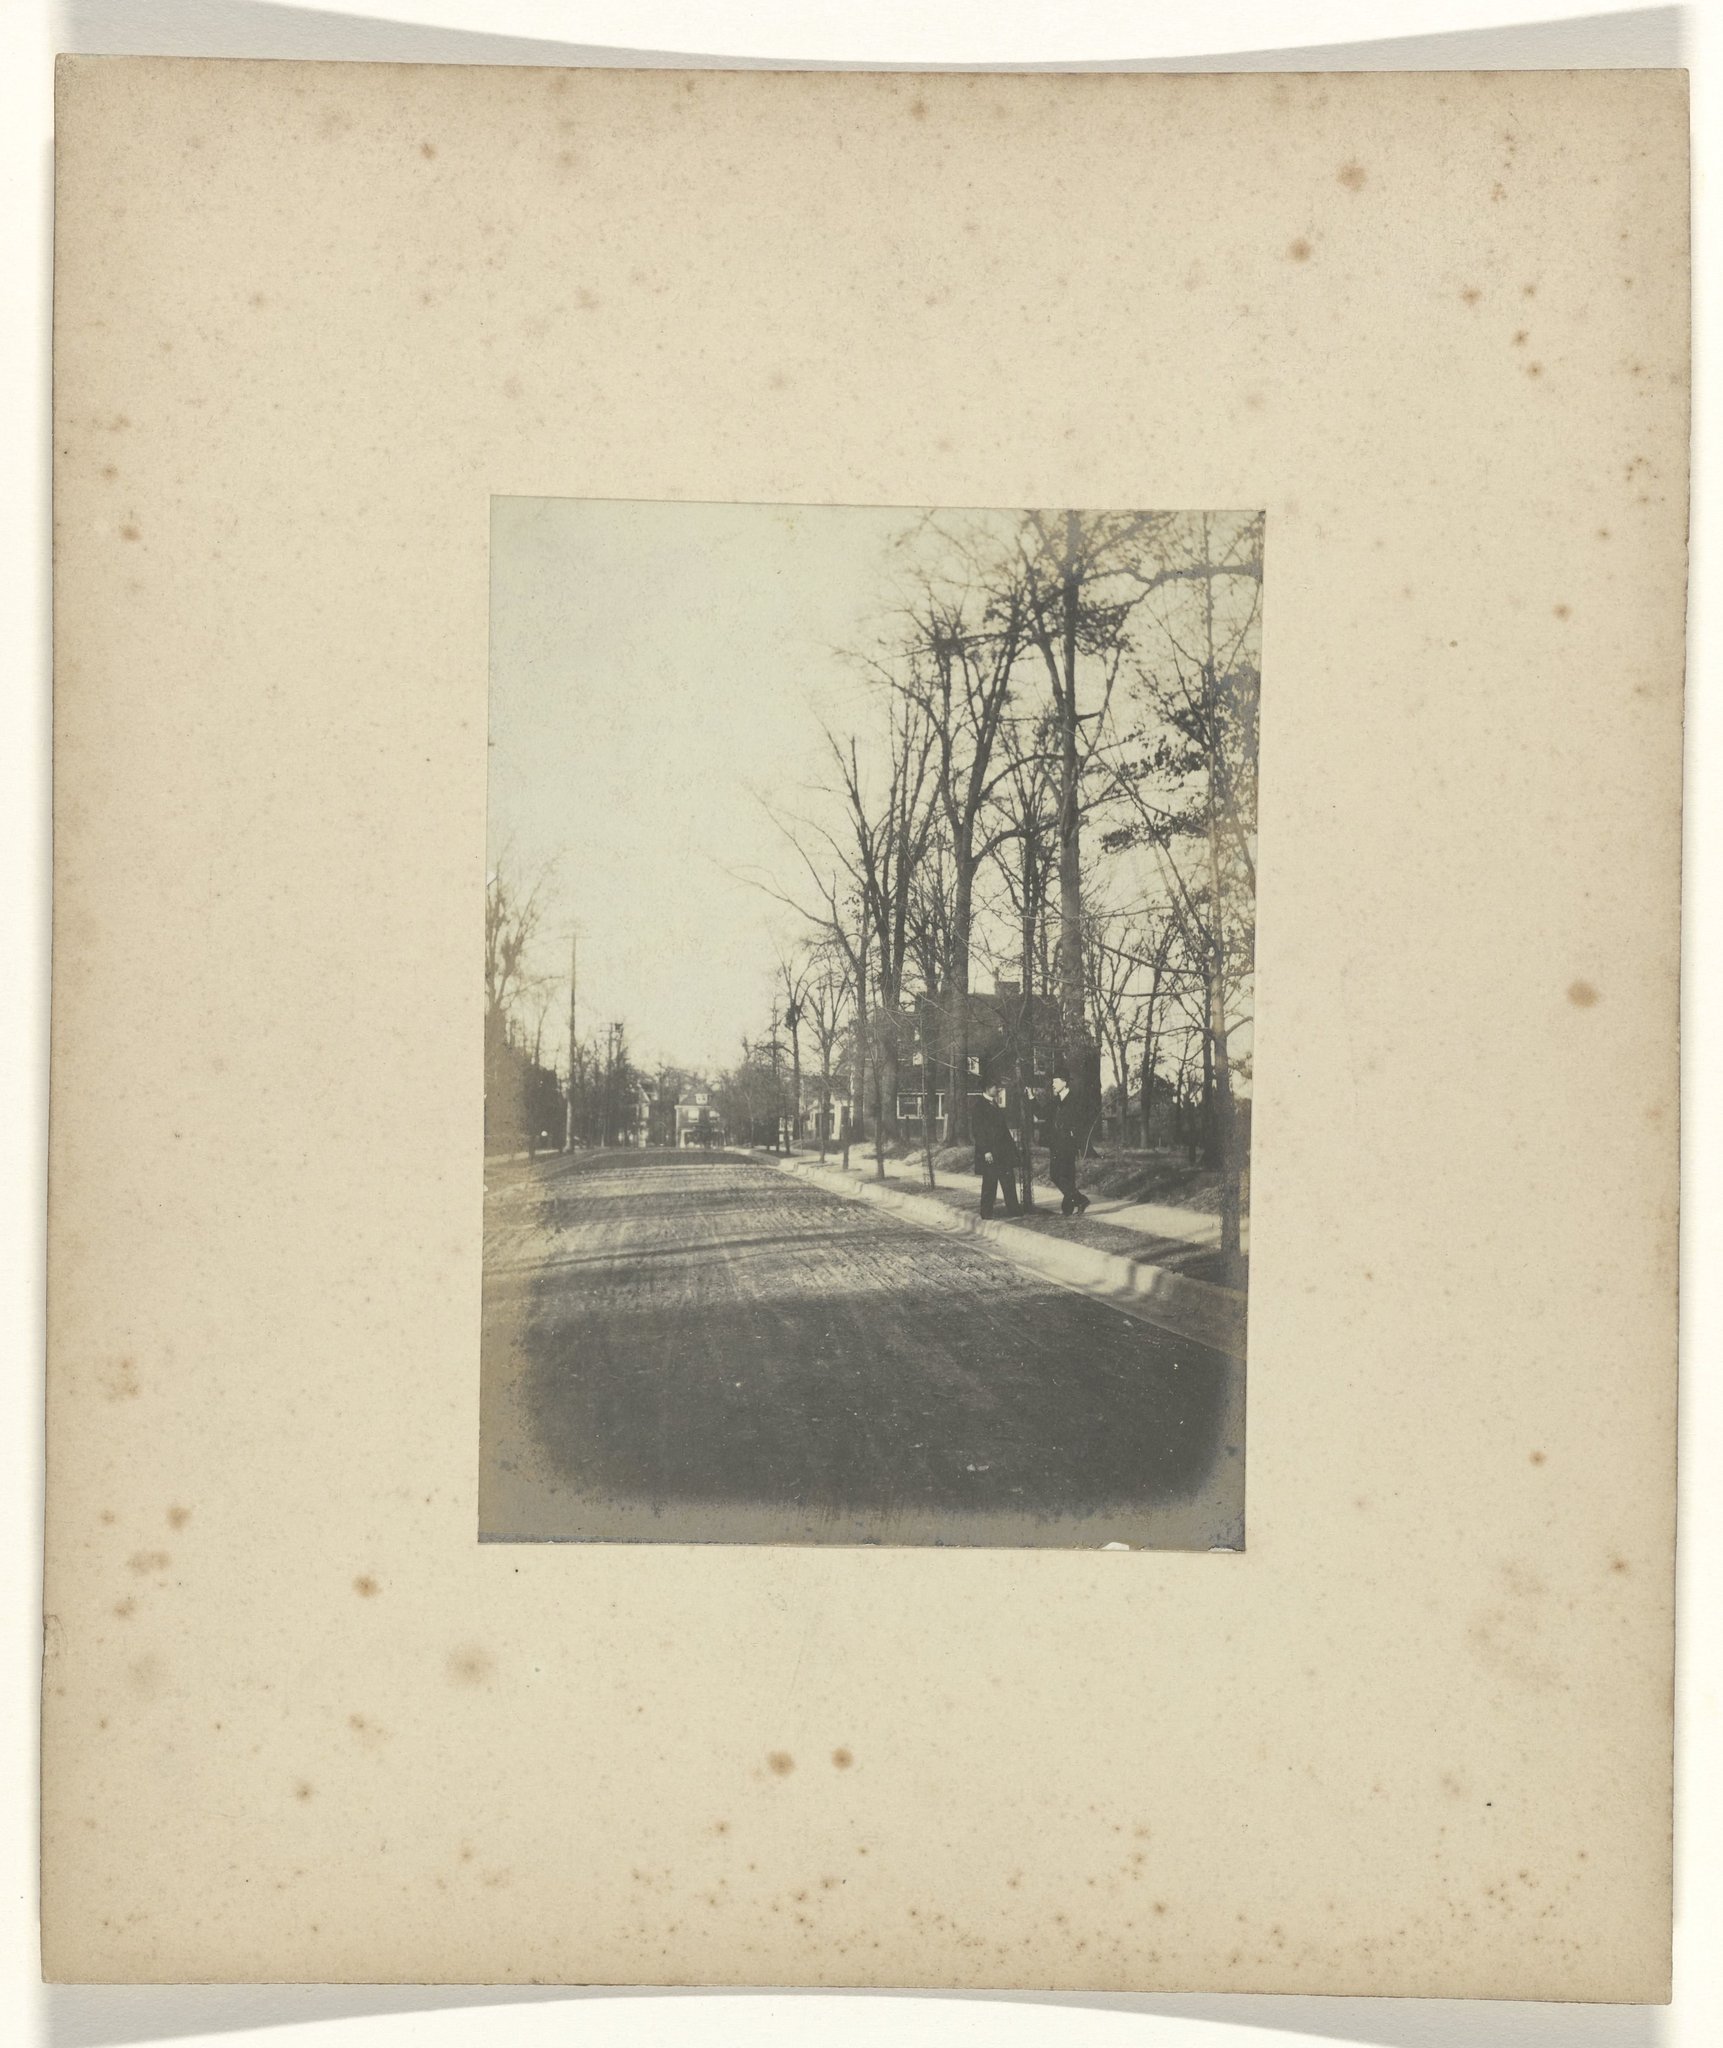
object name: photograph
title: Jan C. Schüller [?] en een andere man op straat tijdens de wereldtentoonstelling in St. Louis (Louisiana Purchase Exposition), 1904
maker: Anonymous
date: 1905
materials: cardboard, paper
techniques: gelatin silver print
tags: missouri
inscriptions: annotation: ‘1 Jan 1905 // Dicht bij Maple arc’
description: Jan C. Schüller [?] en een andere man op straat tijdens de wereldtentoonstelling in St. Louis (Louisiana Purchase Exposition), 1904.